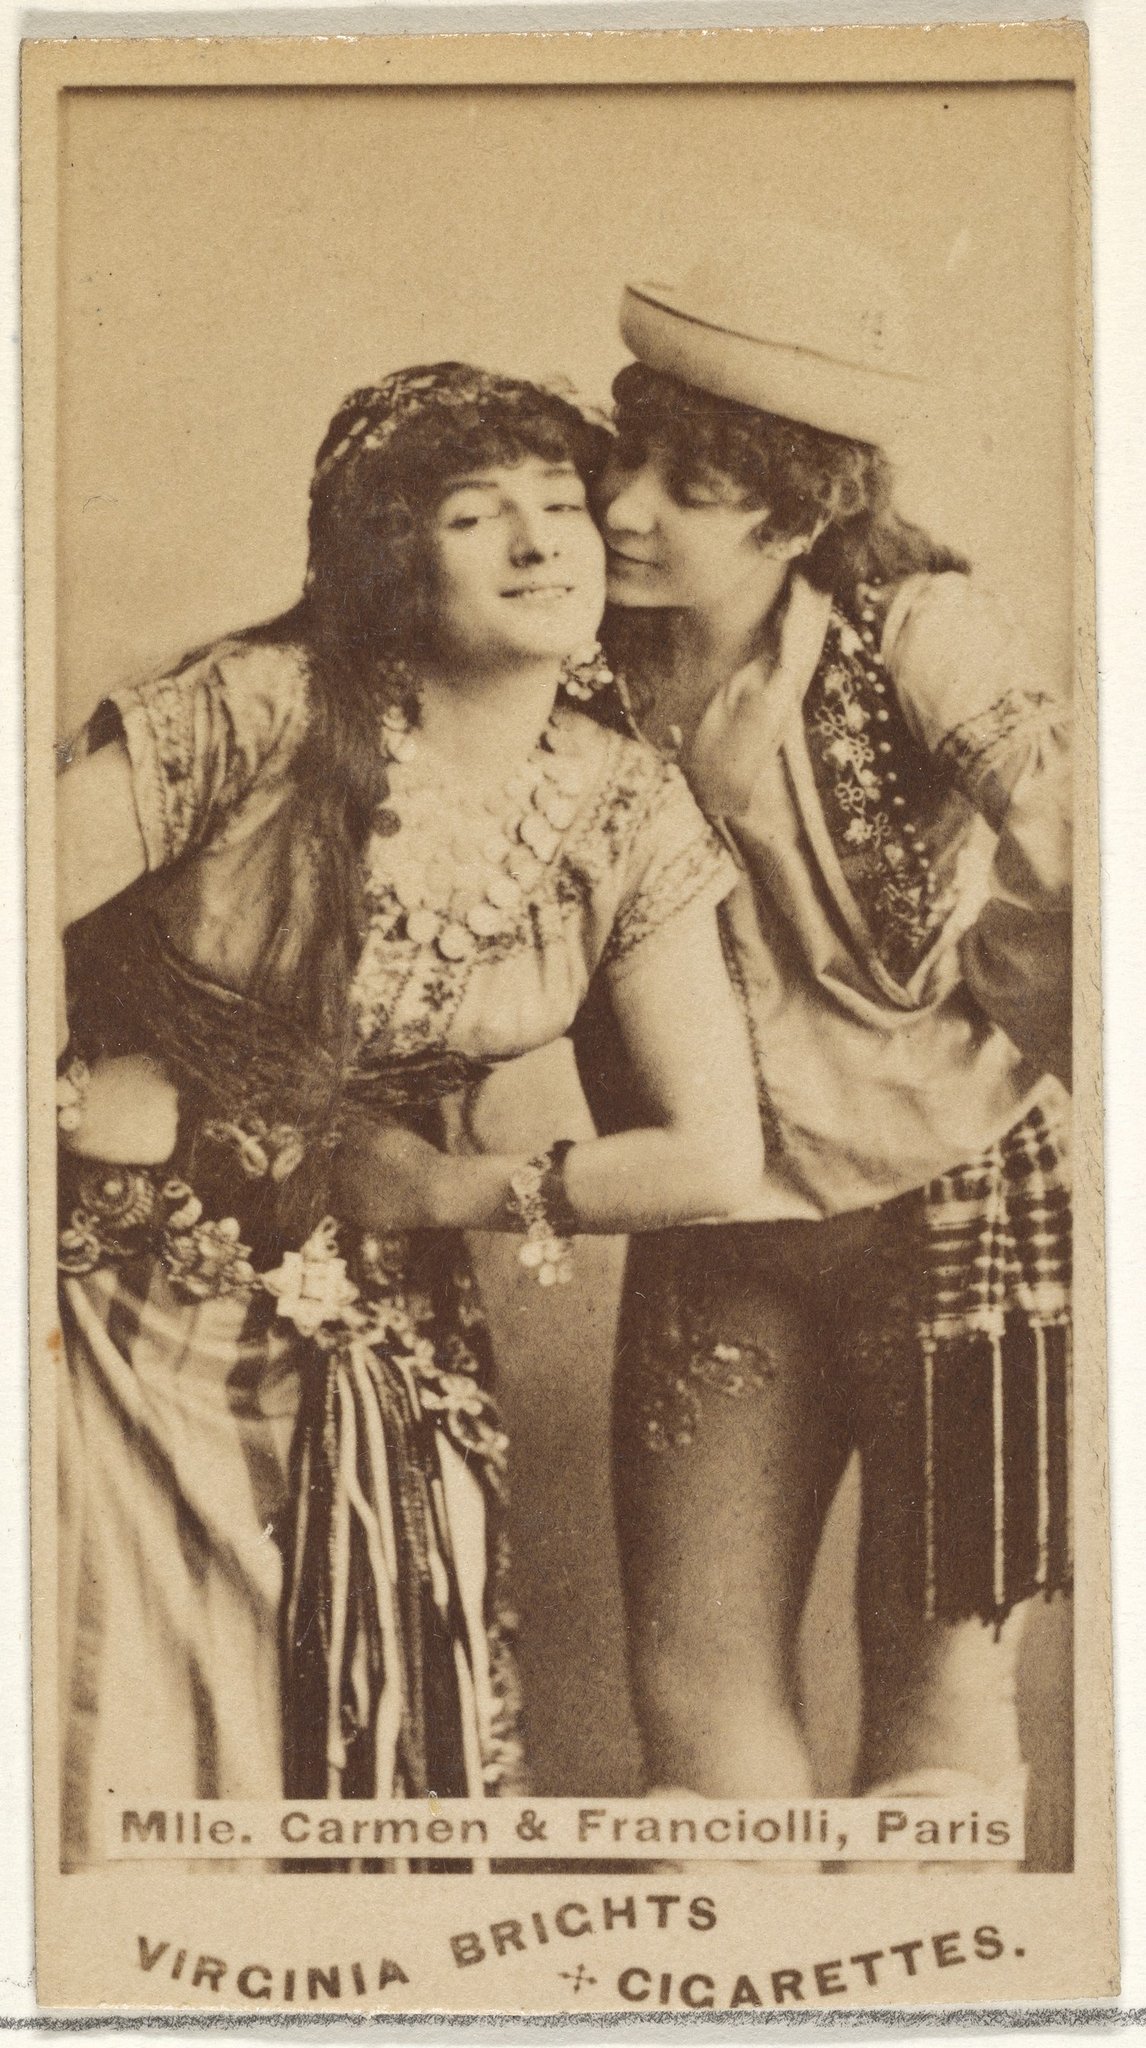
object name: photograph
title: Mlle. Carmen and Franciolli, Paris, from the Actors and Actresses series (N45, Type 1) for Virginia Brights Cigarettes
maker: allen & ginter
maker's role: publisher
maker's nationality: american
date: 1888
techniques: albumen silver print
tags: portraits,women,actresses